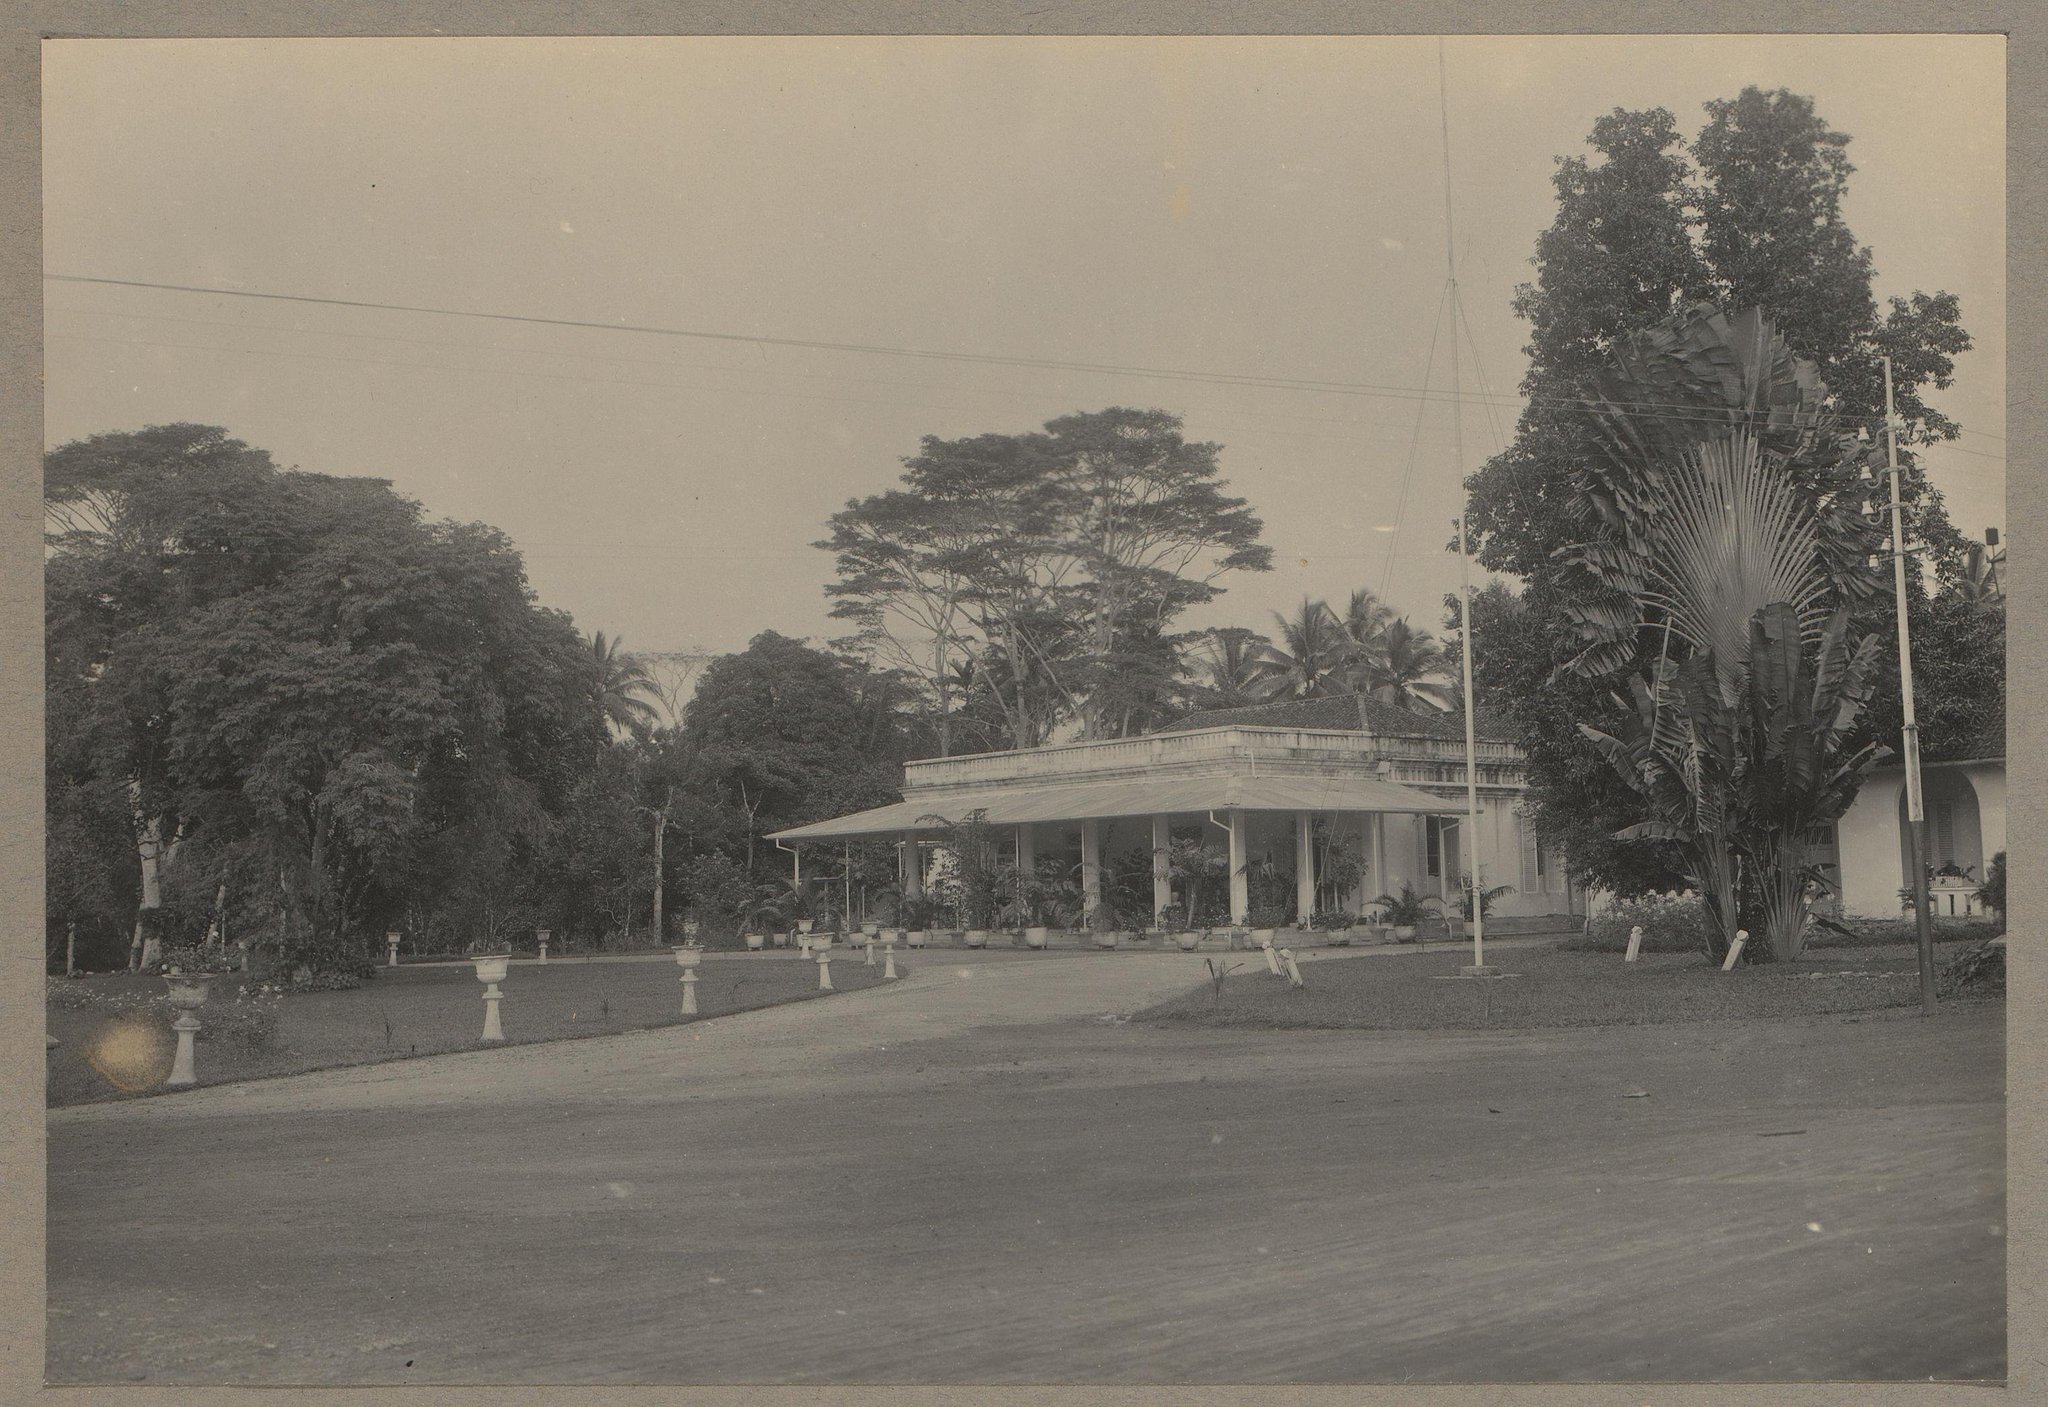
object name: photograph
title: Pangkalpinang Woning van den Resident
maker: Anonymous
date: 1914-1919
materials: photographic support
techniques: gelatin silver print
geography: bangka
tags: robert julius boers, colonial system, colonial governor, mining, villa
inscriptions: inscription: ‘Pangkalpinang Woning van den Resident’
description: Woning van de resident in Pangkalpinang. Onderdeel van het fotoalbum aangeboden aan Robert Julius Boers bij zijn vertrek naar Nederland in 1919 door het personeel van de Banka-tinwinning.